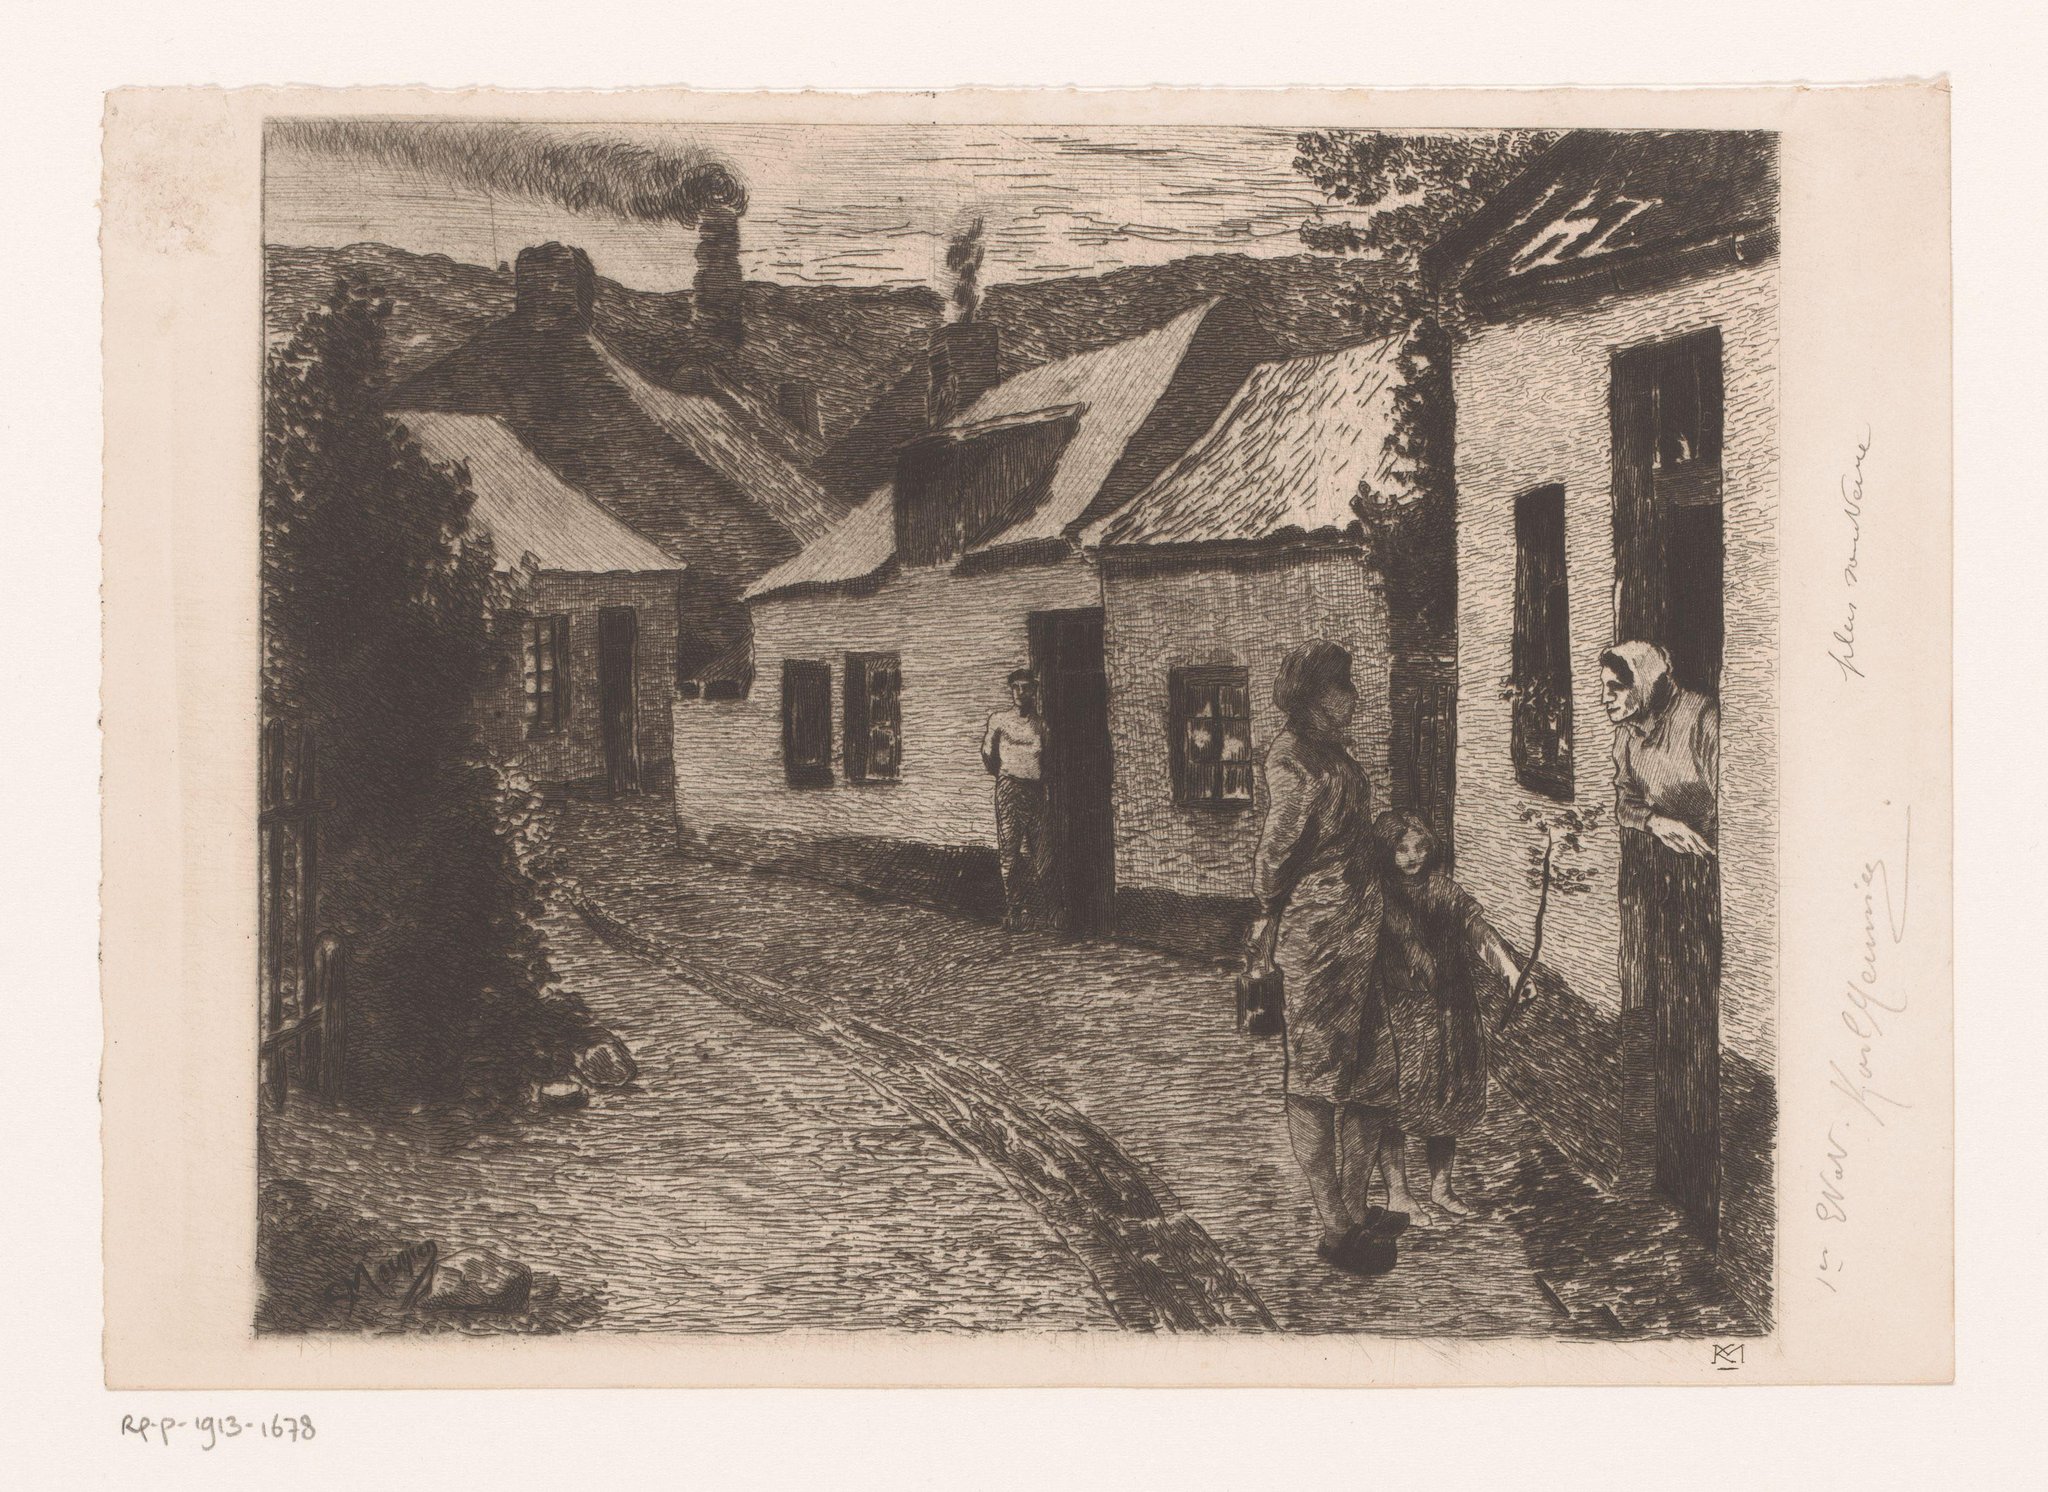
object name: print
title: Moeder en dochter gaan langs de deuren in een arbeidersbuurt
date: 1874-1894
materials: paper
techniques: etching, intaglio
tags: knocking at the door, working class, labourers, street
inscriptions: inscription: ‘1er Etat; plus [...]’, collector's mark: Lugt 2228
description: Het meisje rijkt een tak aan, aan een vrouw in de deuropening.